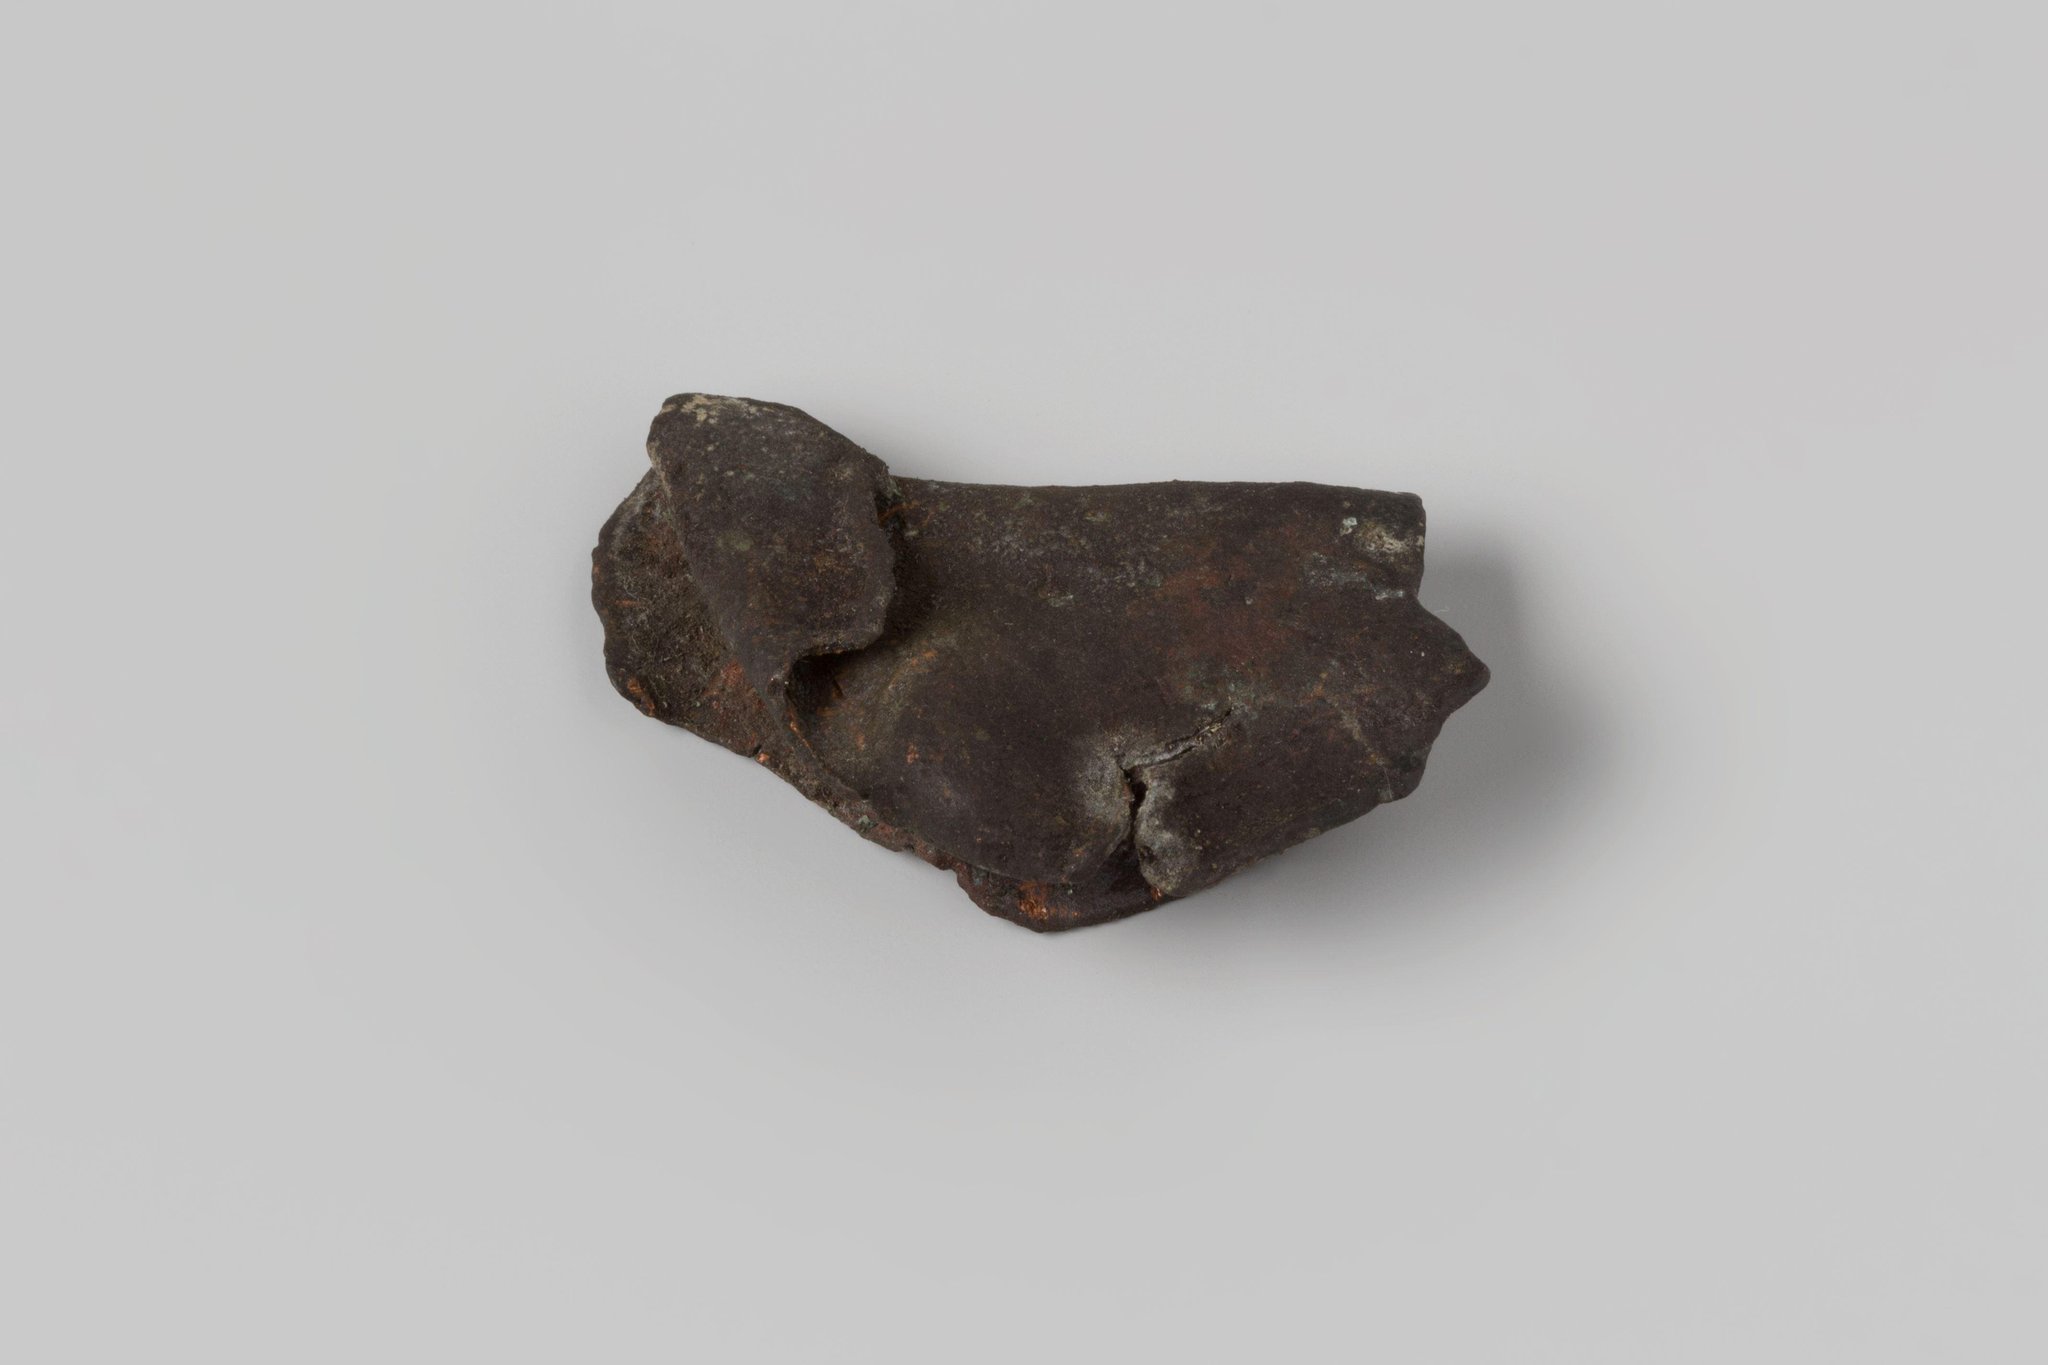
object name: scheepswrakvondst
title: Fragment van koper uit het wrak van de Oost-Indiëvaarder Hollandia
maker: Anonymous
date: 1700-1743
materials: copper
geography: netherlands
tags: verenigde oostindische compagnie, hollandia (schip), annet